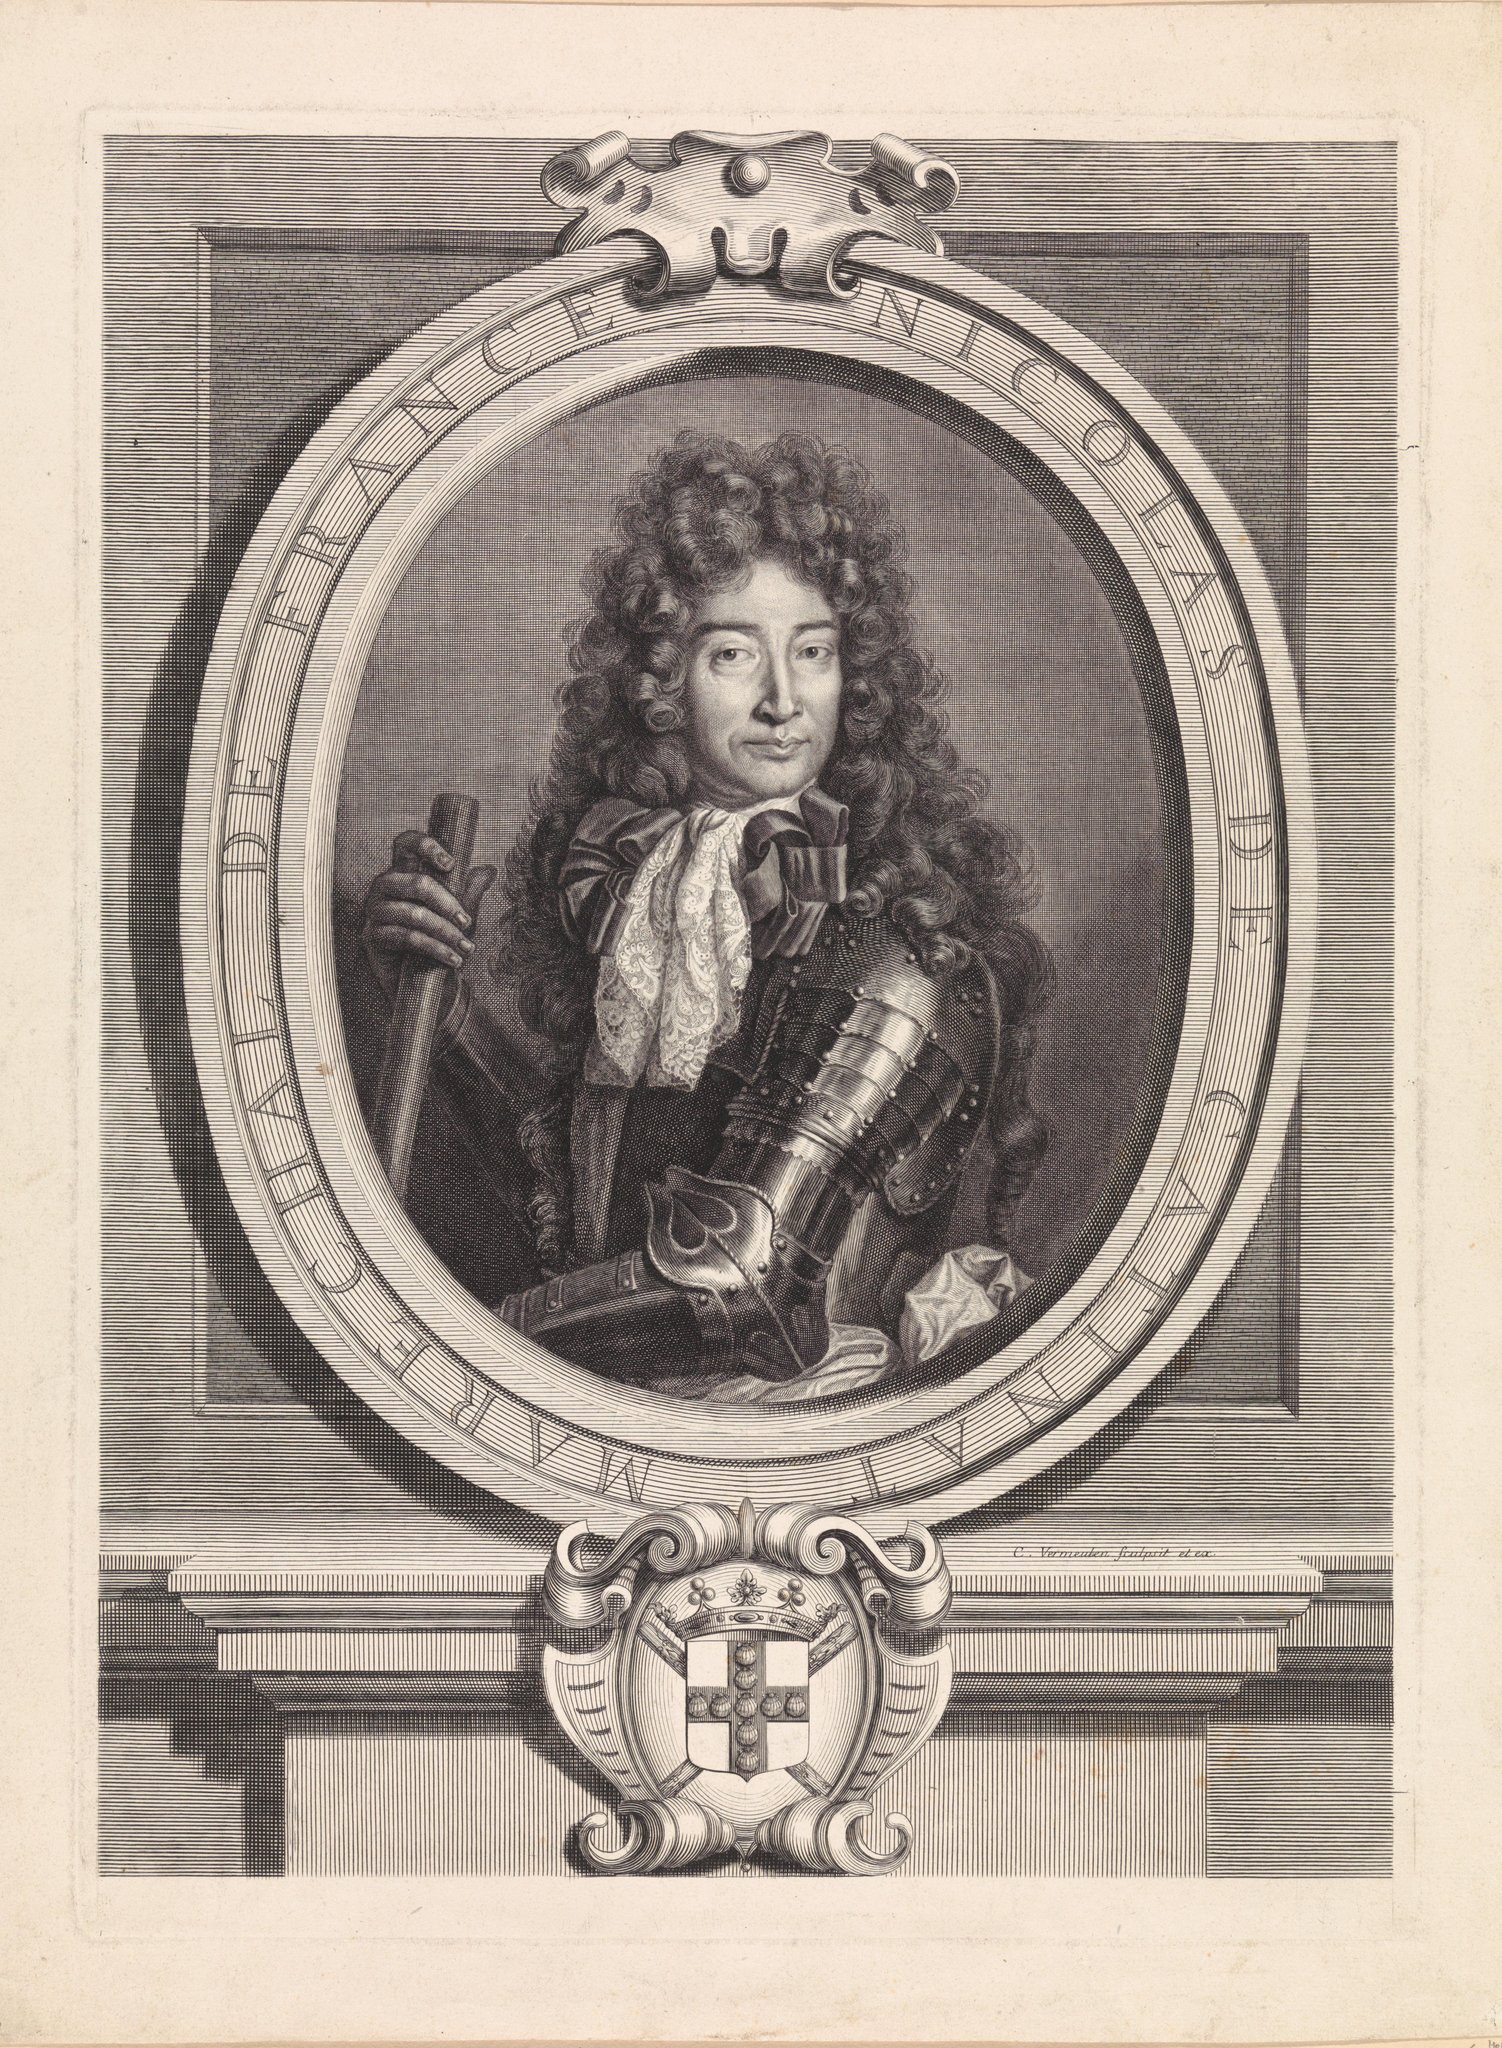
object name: print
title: Portret van de Franse maarschalk Nicolas Catinat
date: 1693-1709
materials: paper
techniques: engraving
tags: maarschalk, commandant, nicolas cantinat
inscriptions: collector's mark: Lugt 240